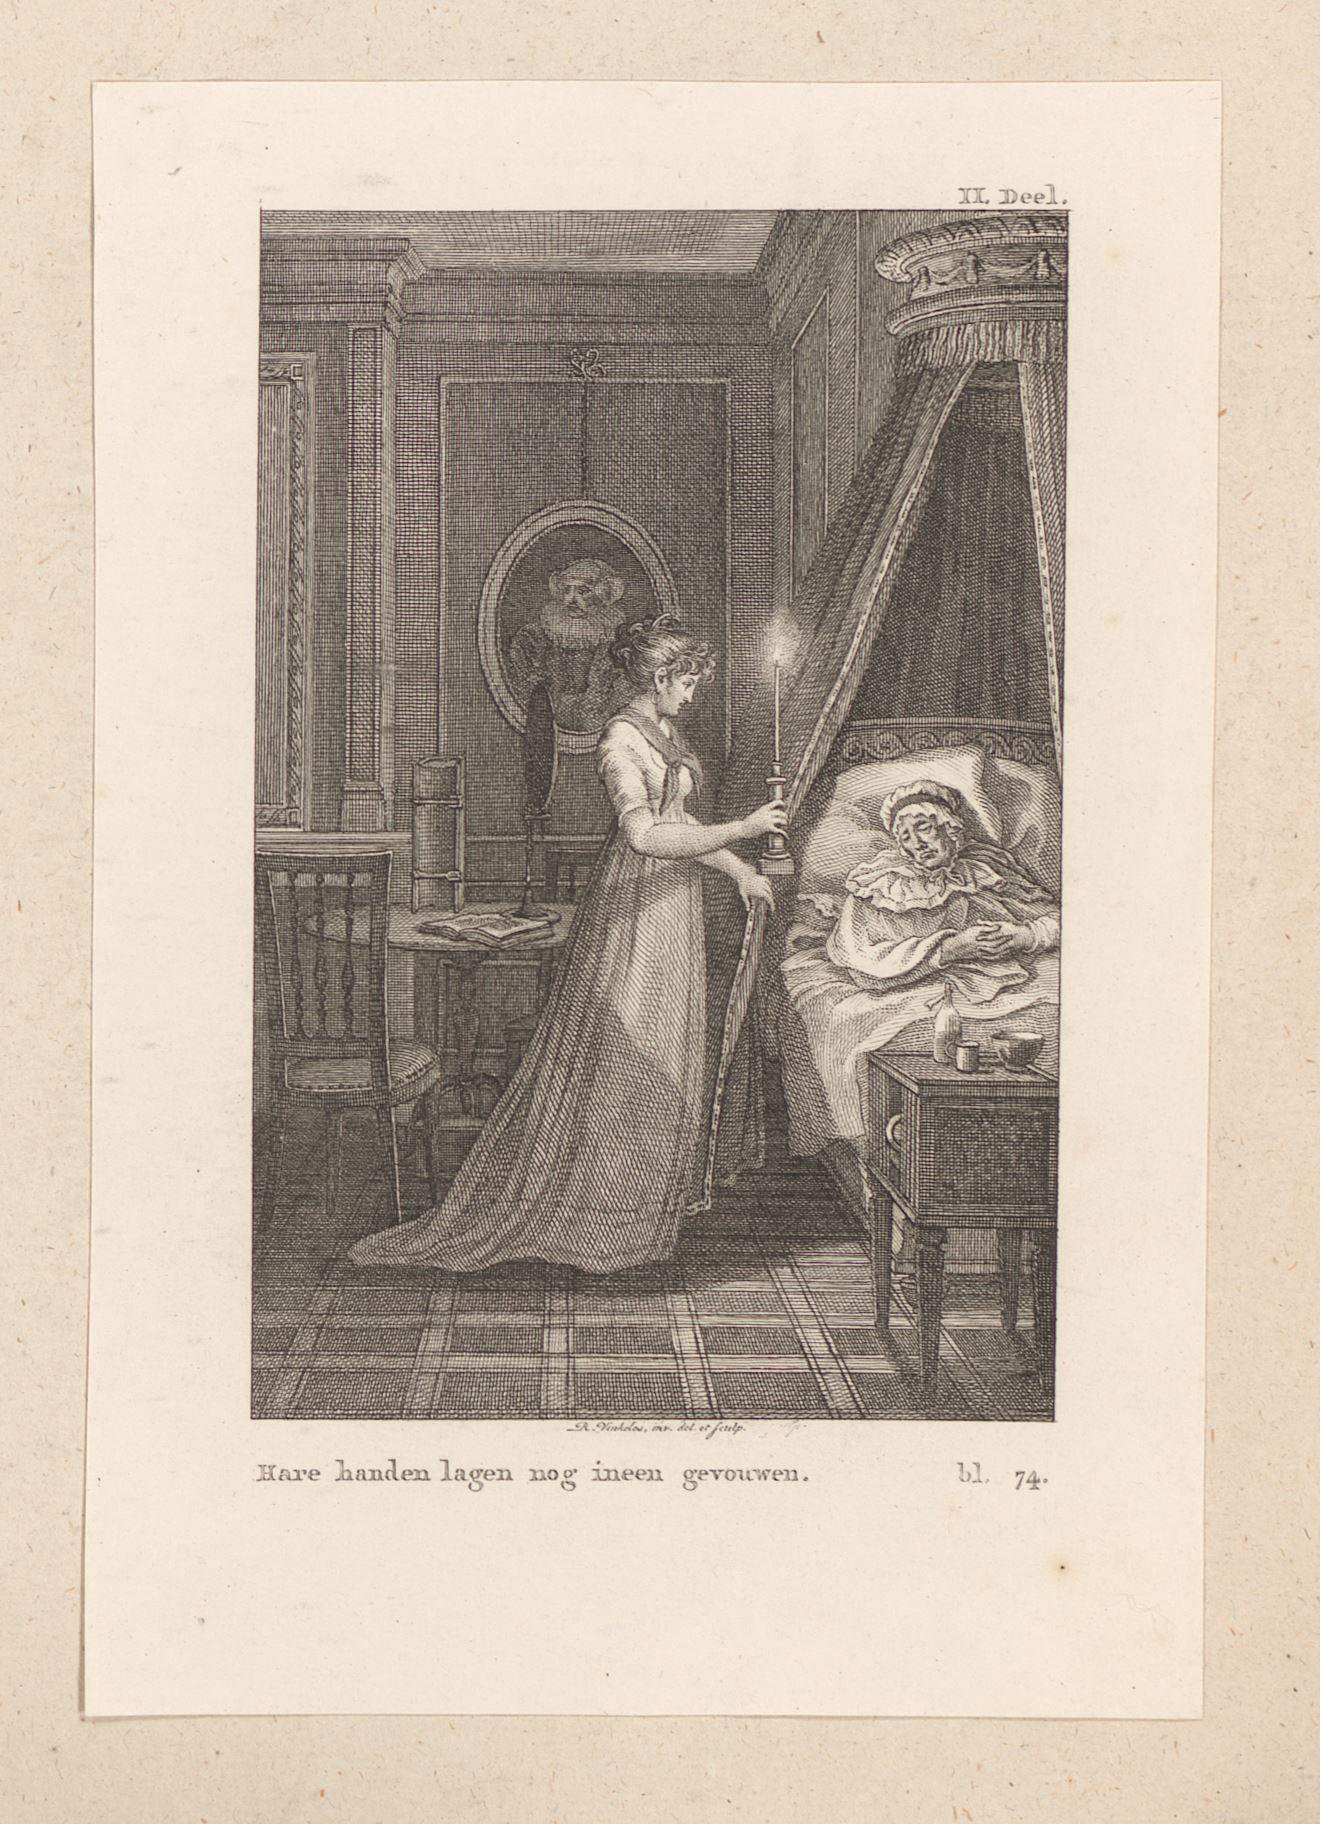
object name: print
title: Susanna Bronkhorst bij het sterfbed van mevrouw Elzevier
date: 1806-1807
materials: paper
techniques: engraving, etching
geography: haarlem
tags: death of human being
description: In een donkere kamer staat een meisje met een kaars bij een oude vrouw, liggend in bed. Zij heeft haar ogen gesloten en haar handen gevouwen. Onder de prent de tekst: Hare handen lagen nog ineen gevouwen ... De prent maakt deel uit van een album.